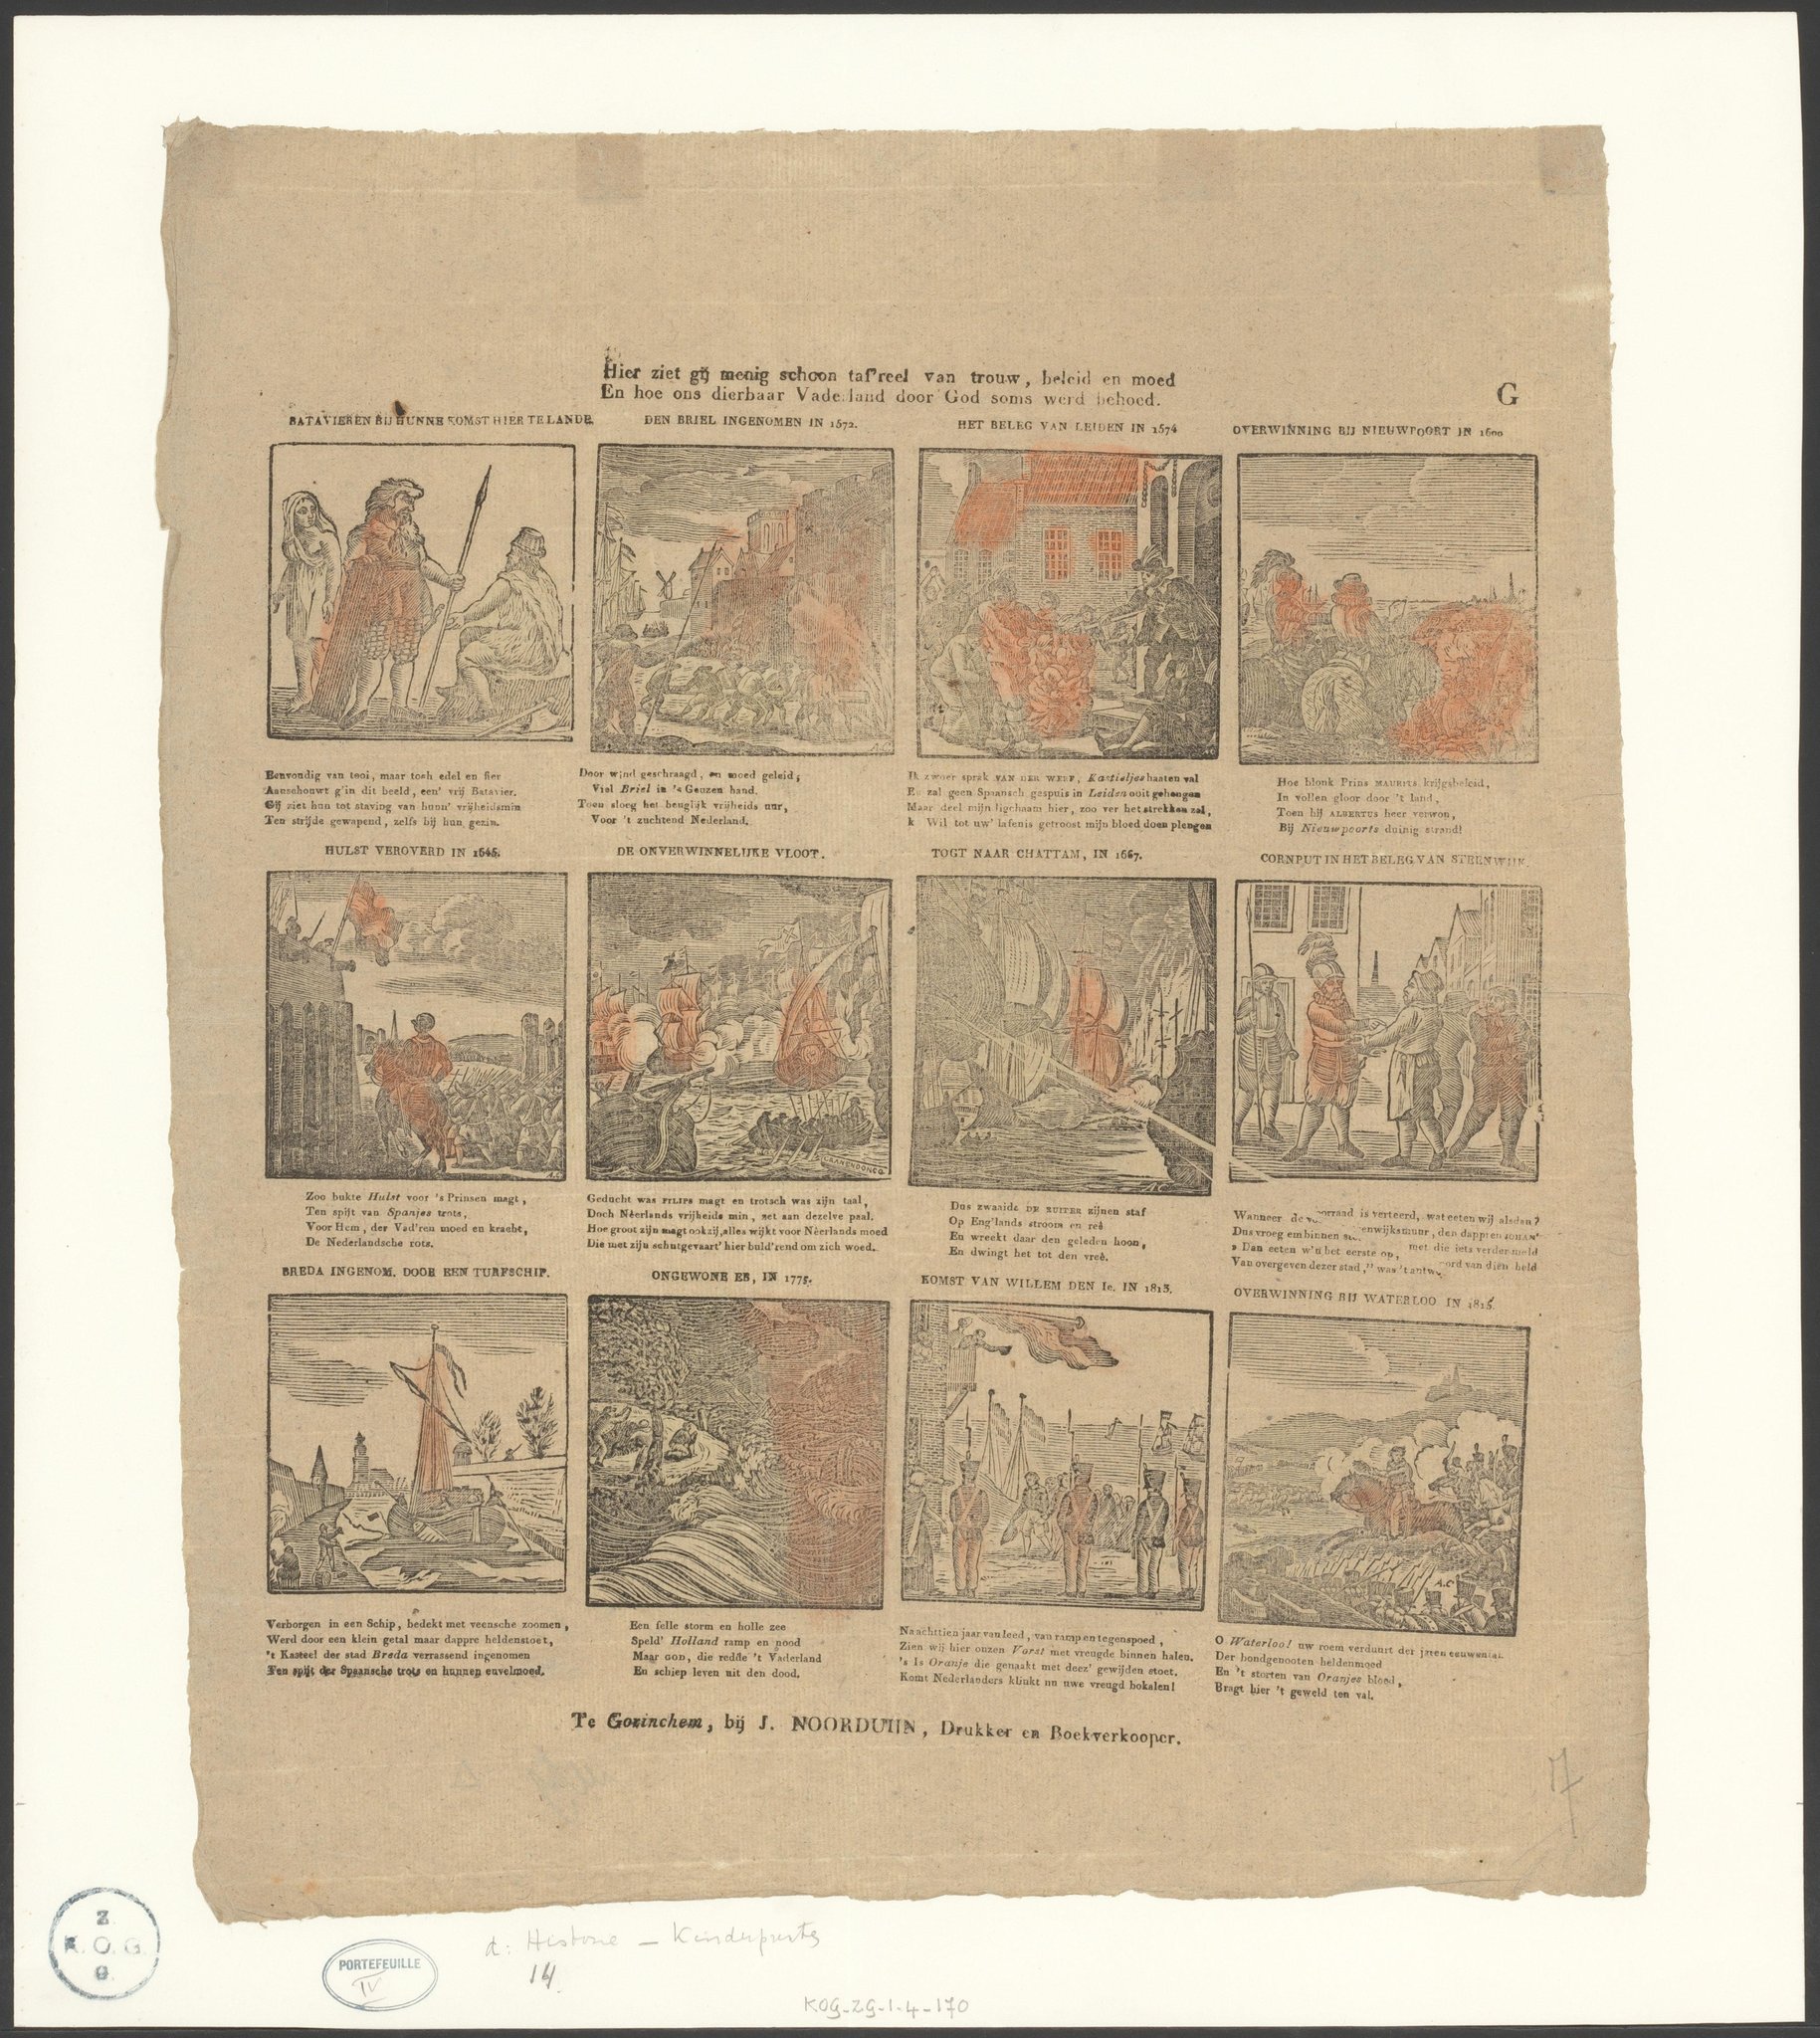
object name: popular print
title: Hier ziet gij menig schoon taf'reel van trouw, beleid en moed / En hoe ons dierbaar Vaderland door God soms werd behoed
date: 1819-1840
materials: paper, watercolor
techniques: hand coloring, letterpress printing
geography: gorinchem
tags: william i of the netherlands, battle (+ naval force), battle (+ land forces), waterloo, leiden, battle of nieuwpoort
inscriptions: collector's mark: Lugt 2228, collector's mark: Lugt 1641, collector's mark: